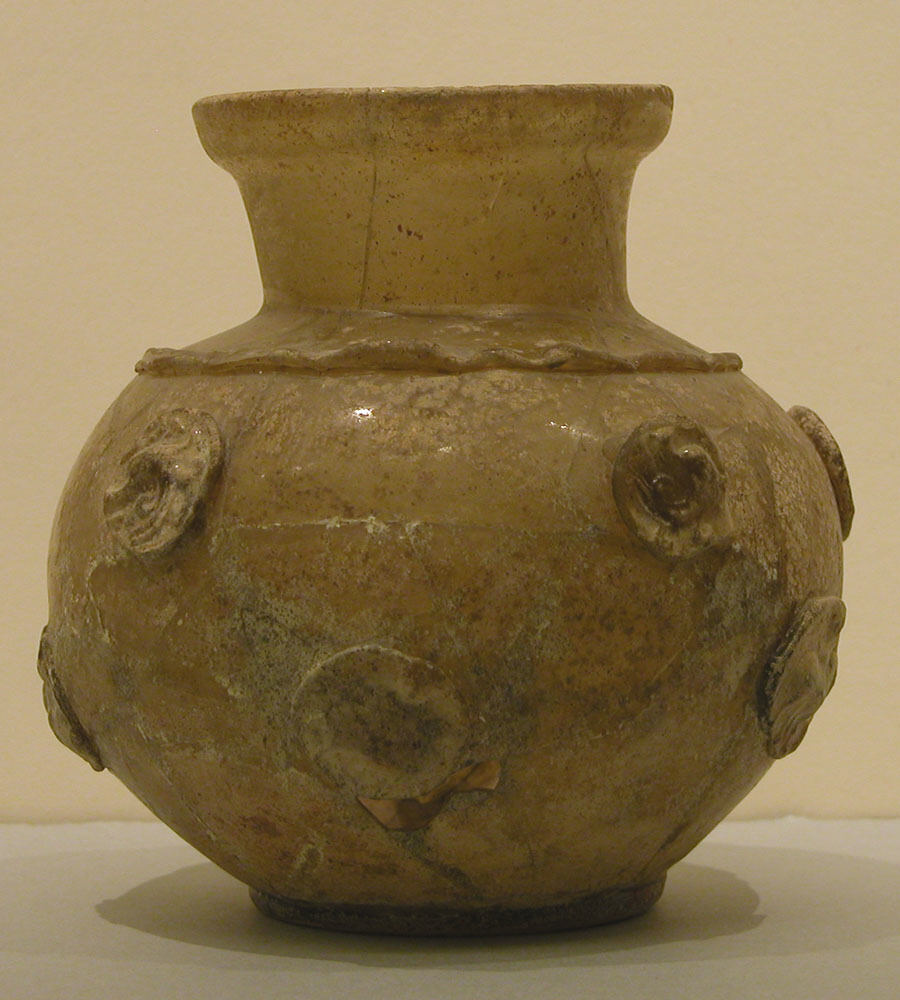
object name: vase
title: Vase with Five Discs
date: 701-800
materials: glass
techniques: glassblowing, stamping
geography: iraq